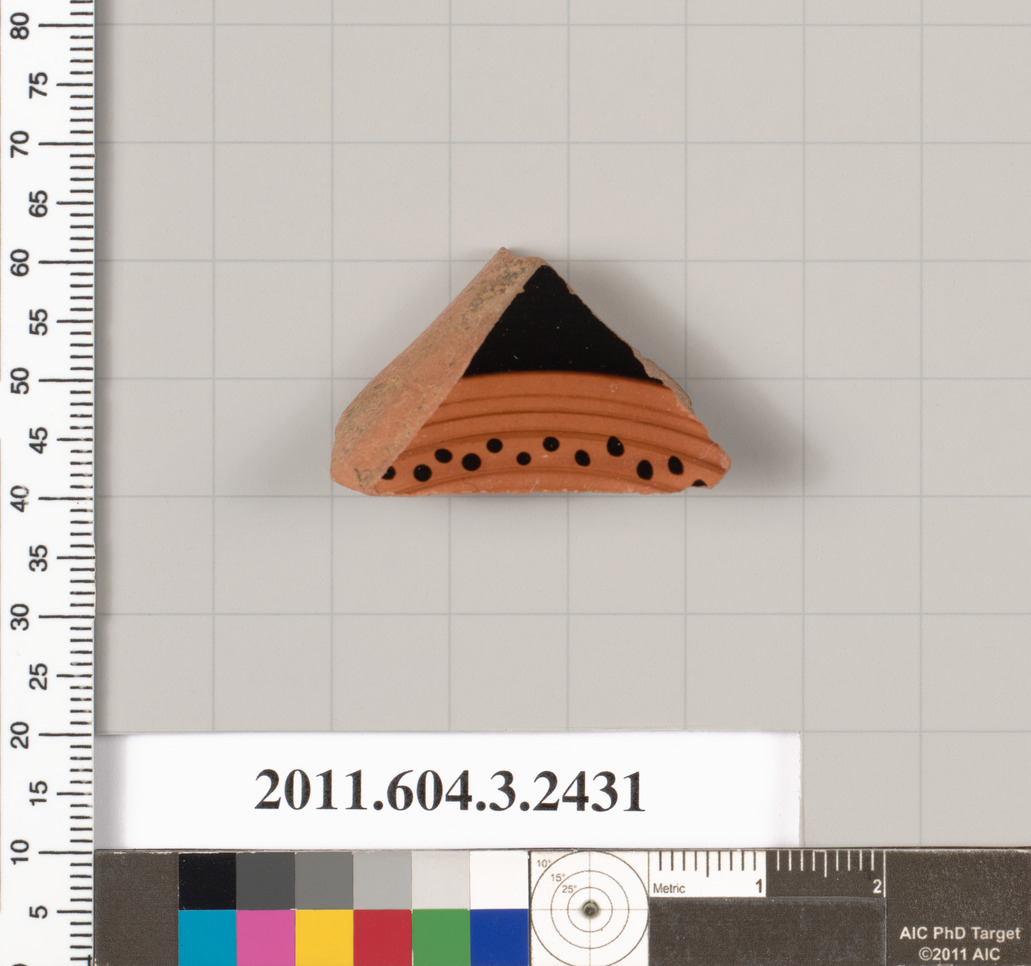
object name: kylix fragment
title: Terracotta fragment of a kylix (drinking cup)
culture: greek, attic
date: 525-501 BCE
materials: terracotta